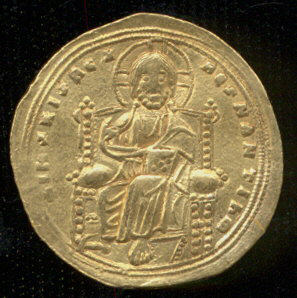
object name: solidus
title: Histamenon of Romanos III Argyros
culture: byzantine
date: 1028-1034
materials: gold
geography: constantinople